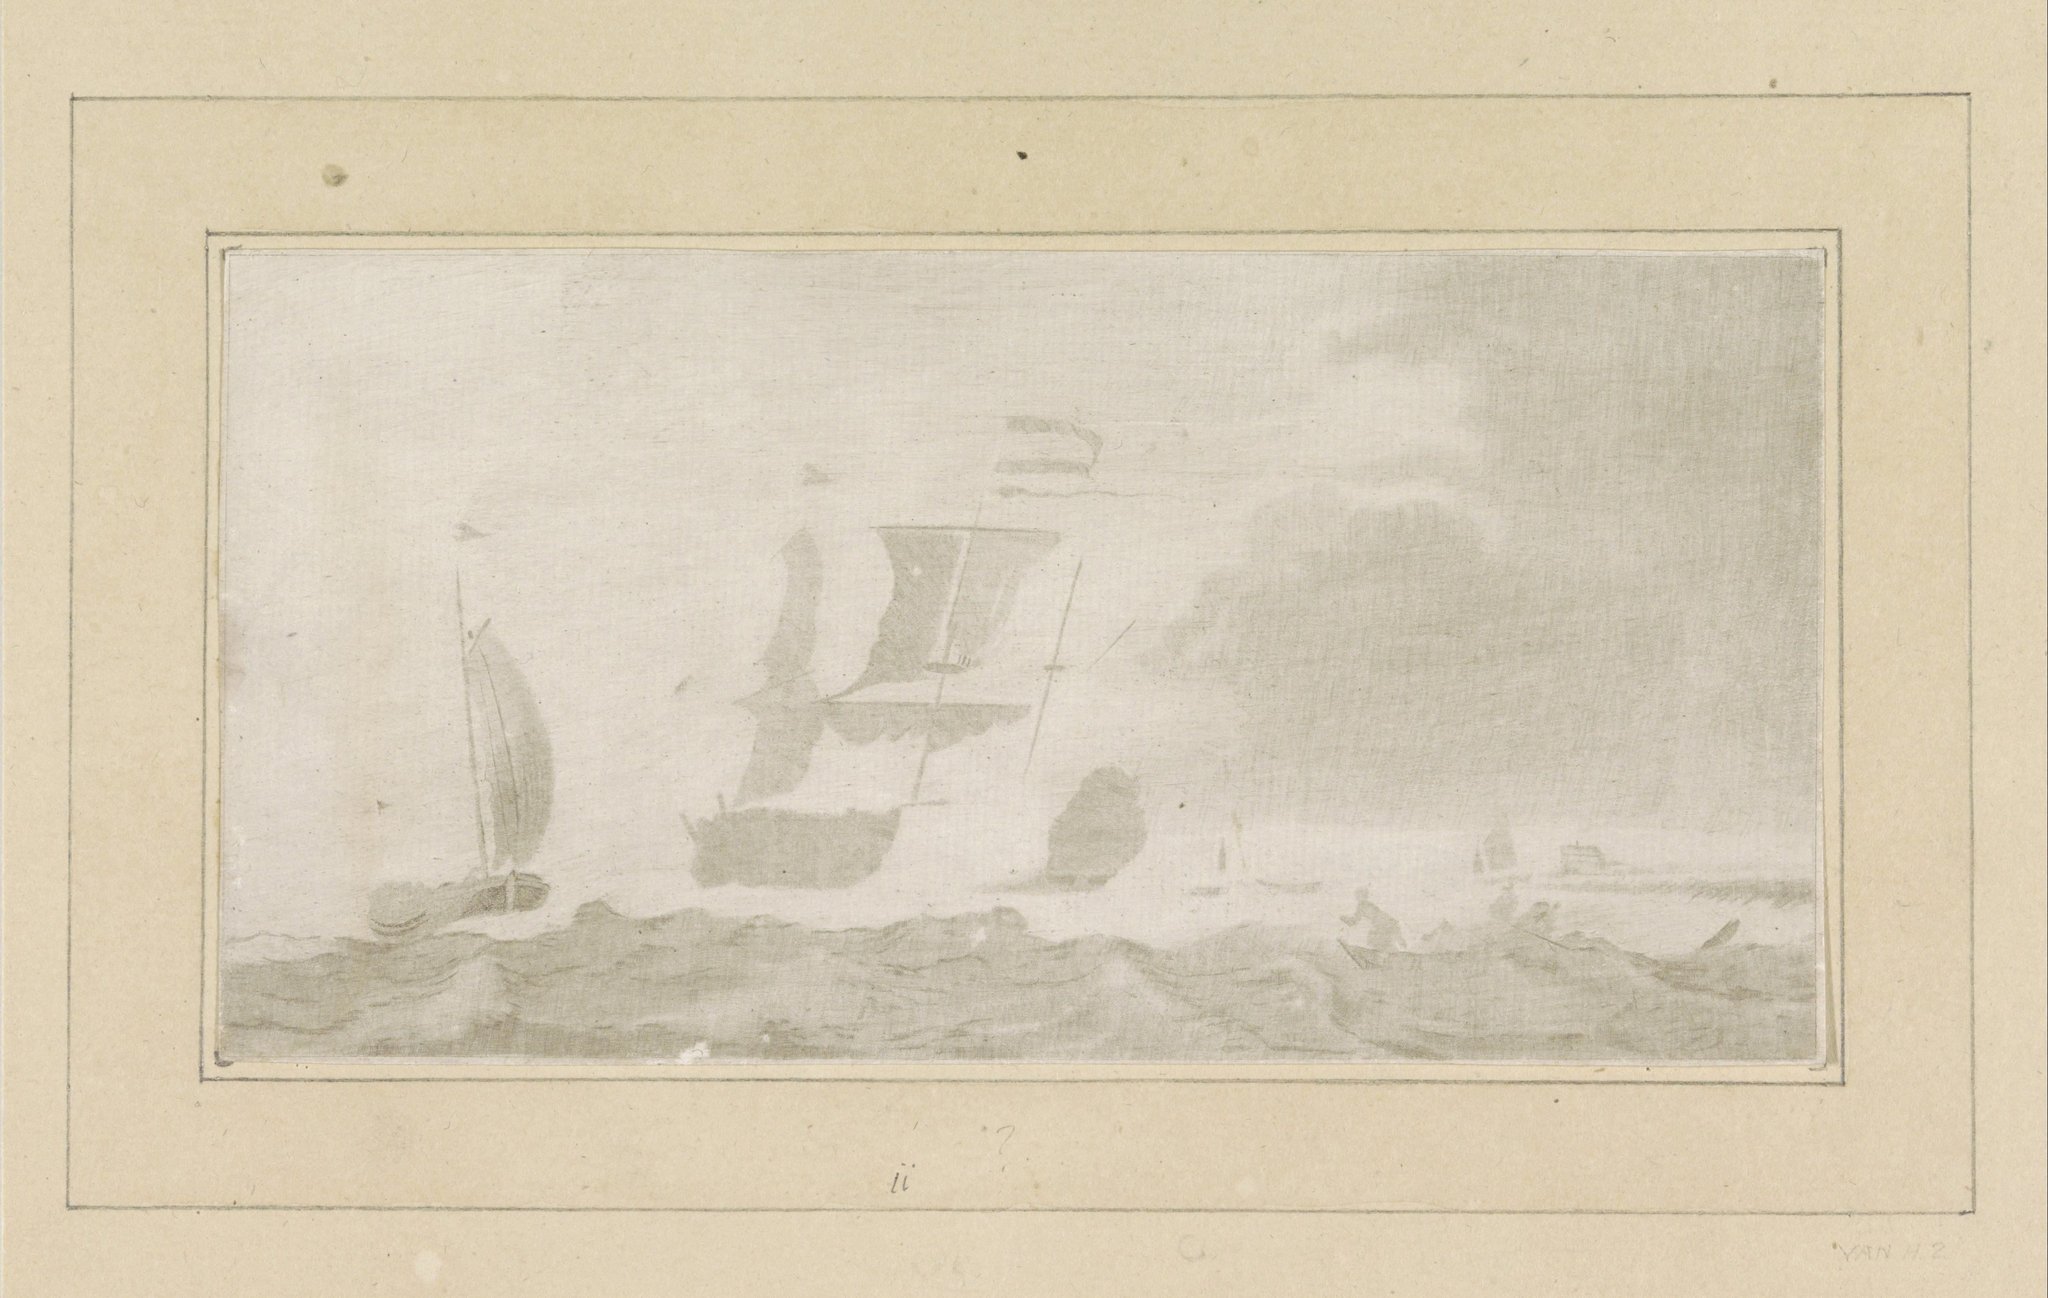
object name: print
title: Oorlogsschip op het IJ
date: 1768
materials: paper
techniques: etching, roulette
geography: amsterdam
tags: sailing-ship, sailing-boat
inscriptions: collector's mark: Lugt 2228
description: Een oorlogsschip op het IJ voor Amsterdam. Links een zeilschip, rechts een roeiboot met vissers.